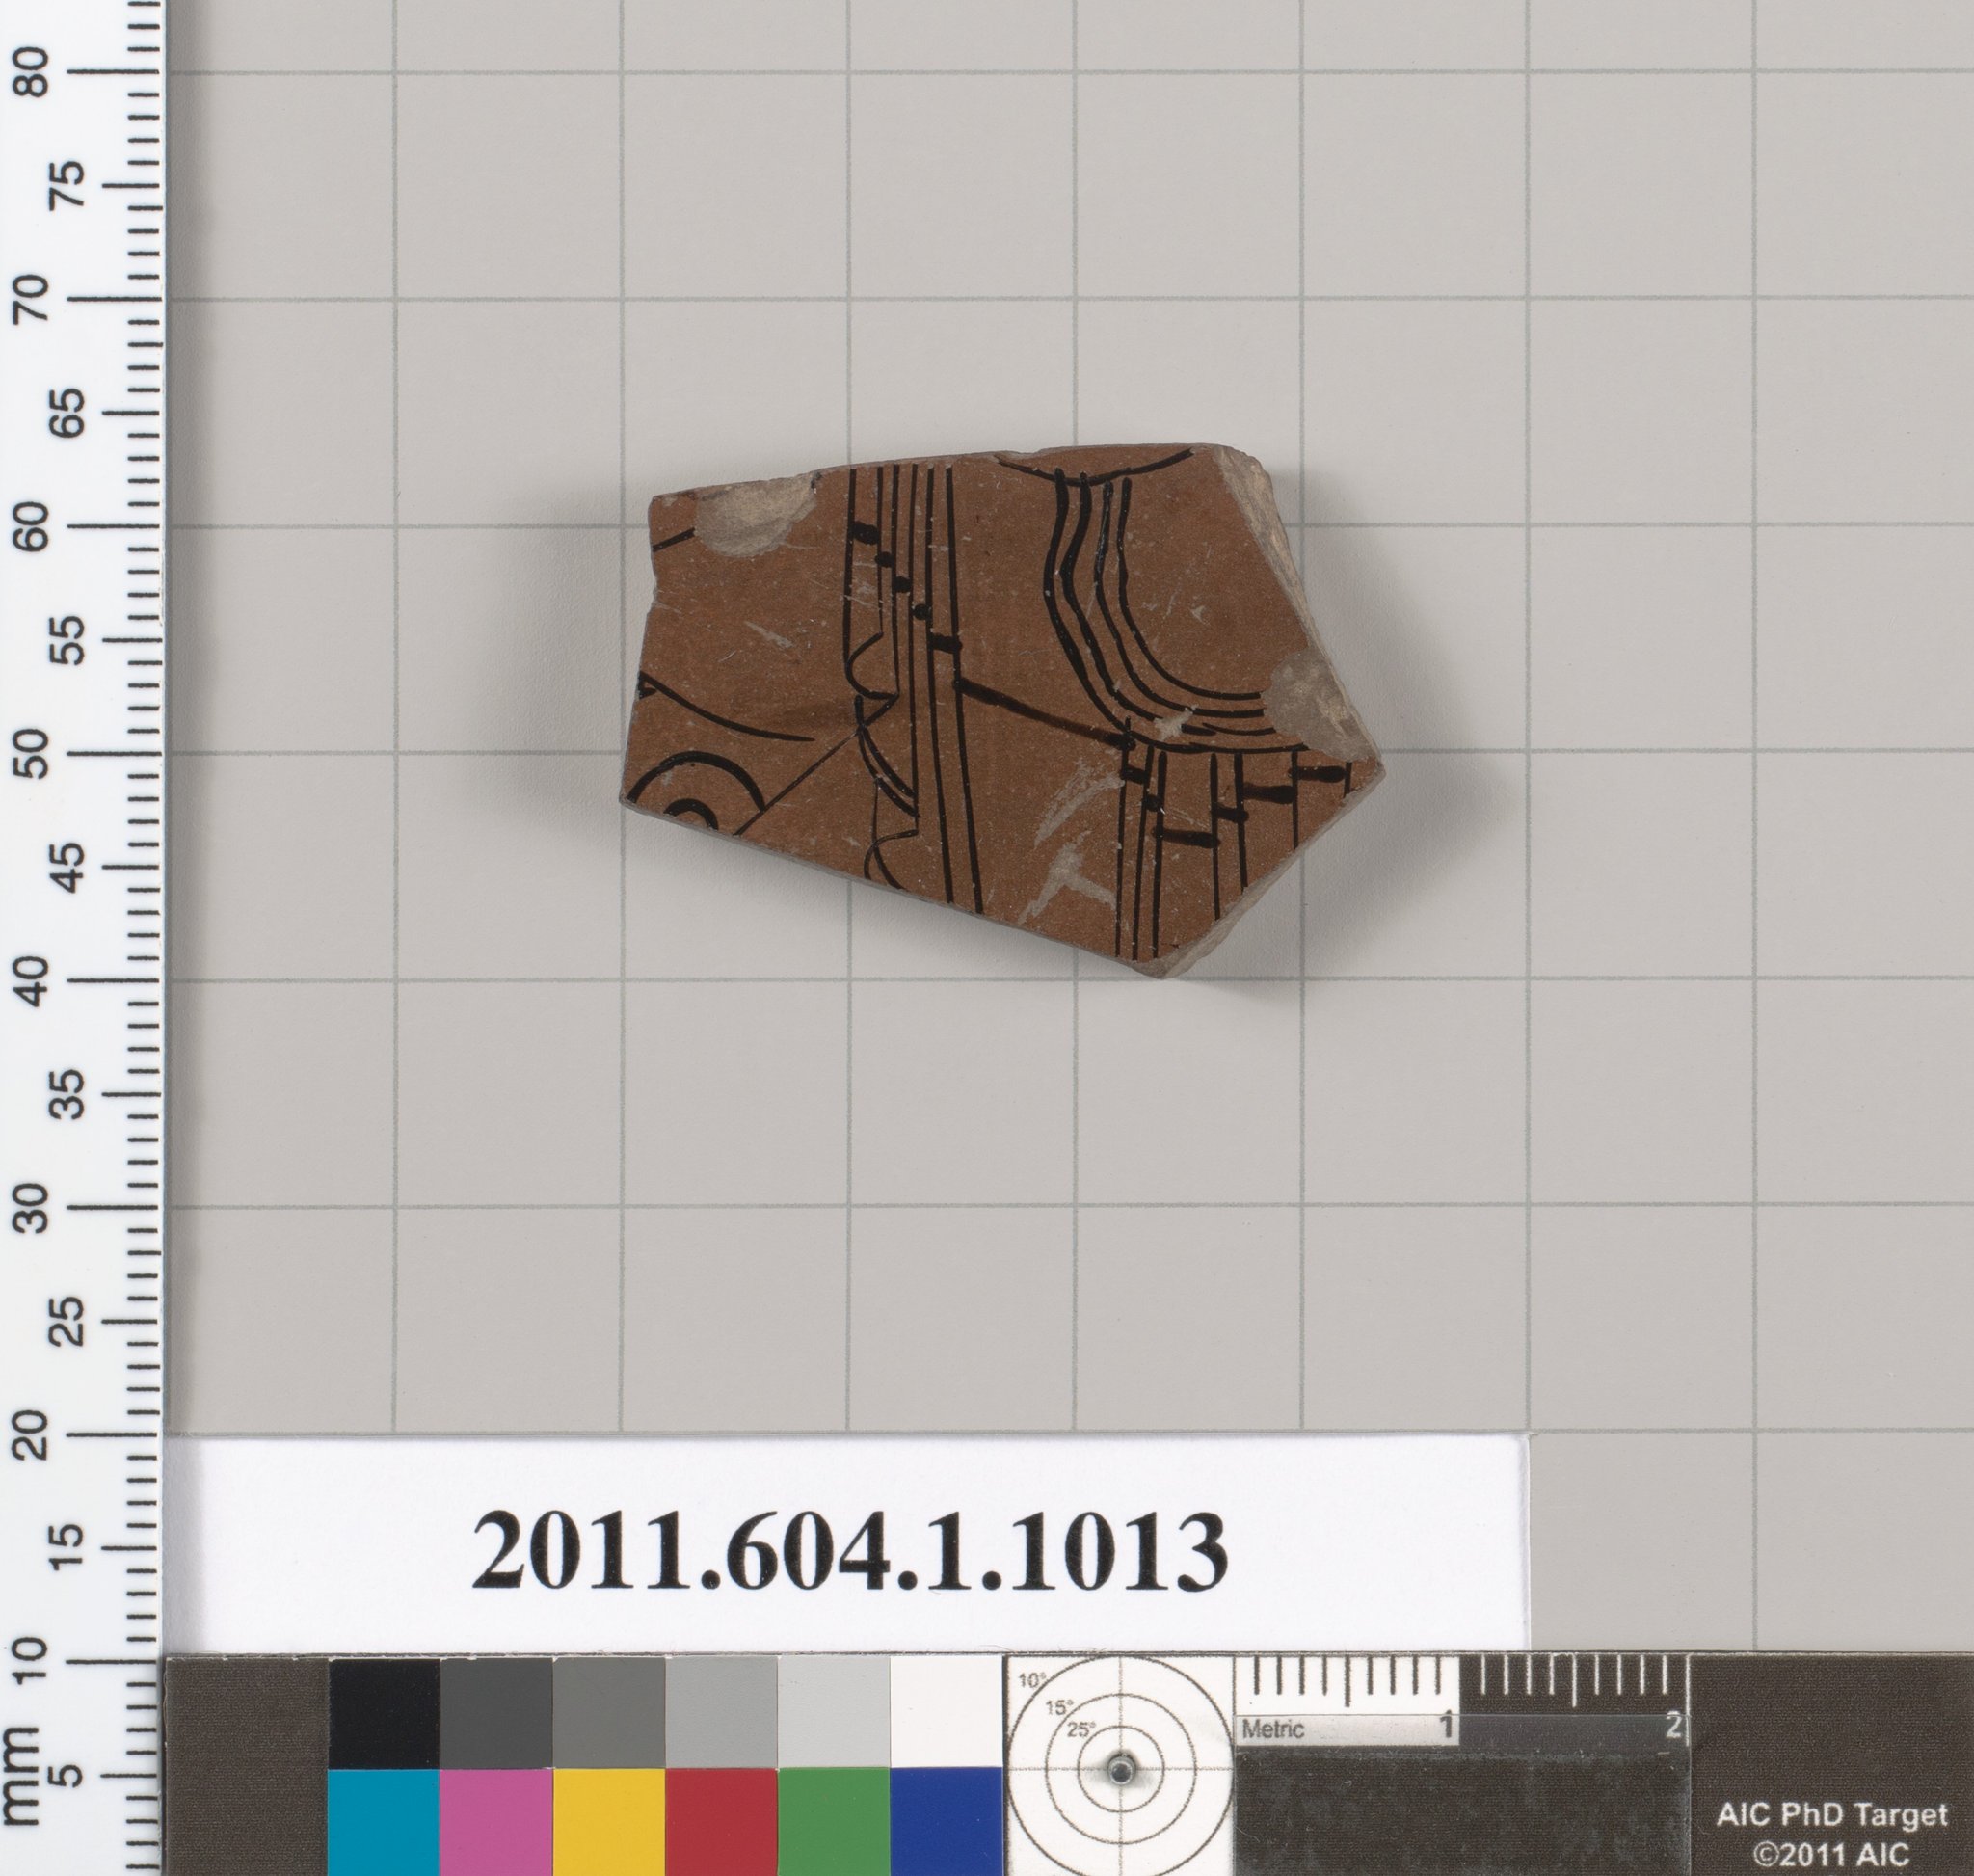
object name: kylix fragment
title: Terracotta fragment of a kylix (drinking cup)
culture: greek, attic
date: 490-480 BCE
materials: terracotta